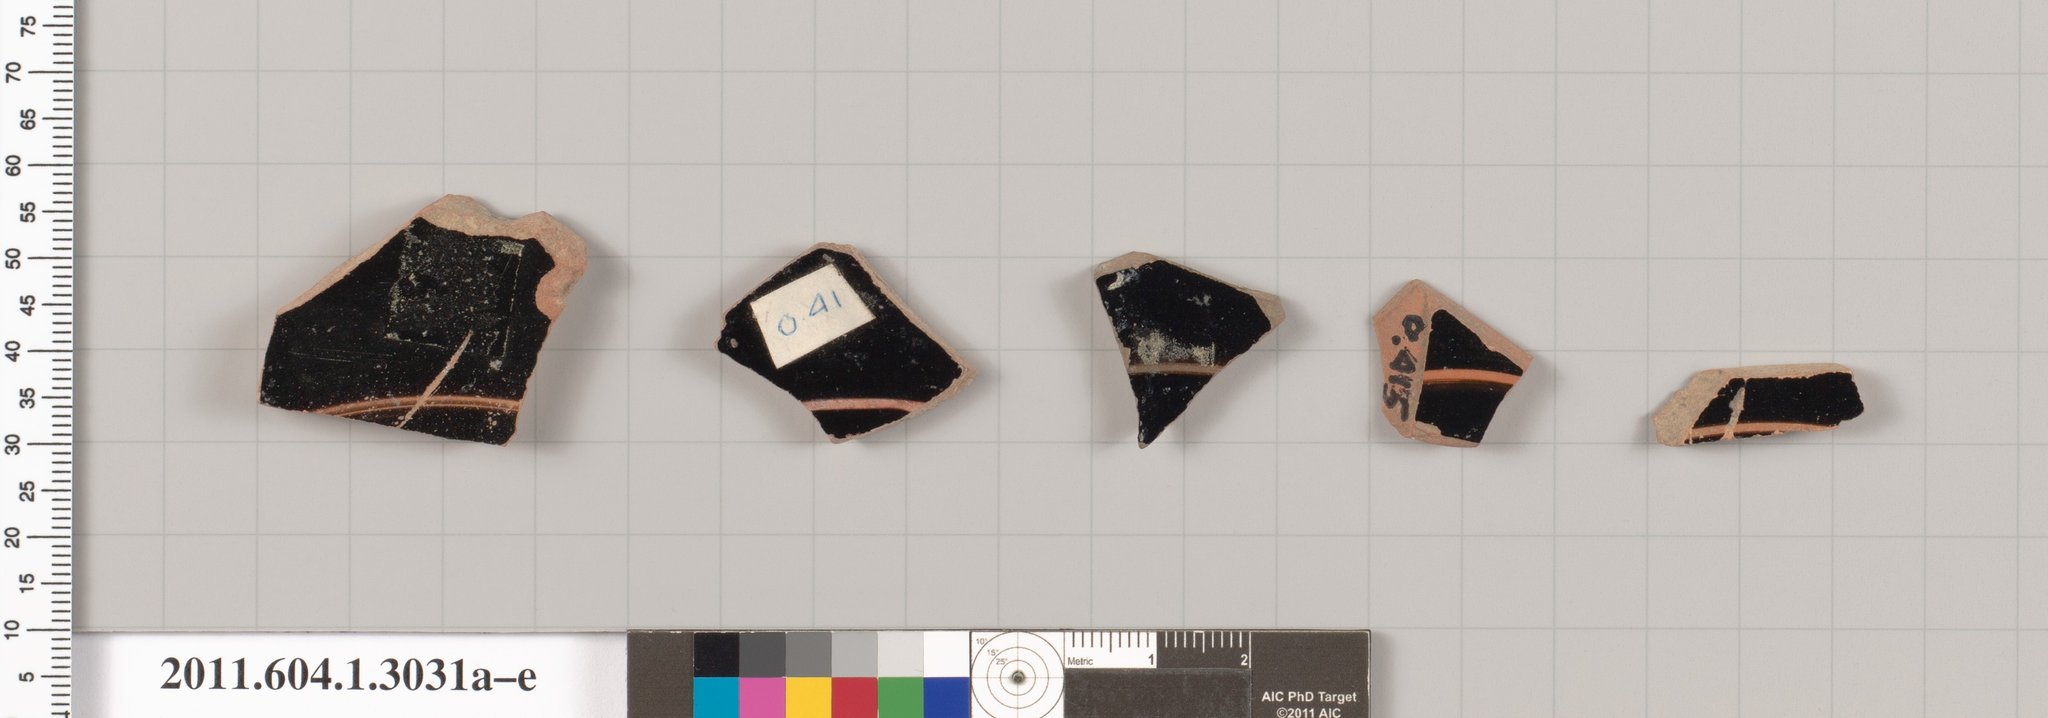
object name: kylix fragment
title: Terracotta fragments of kylikes (drinking cups)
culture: greek, attic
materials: terracotta